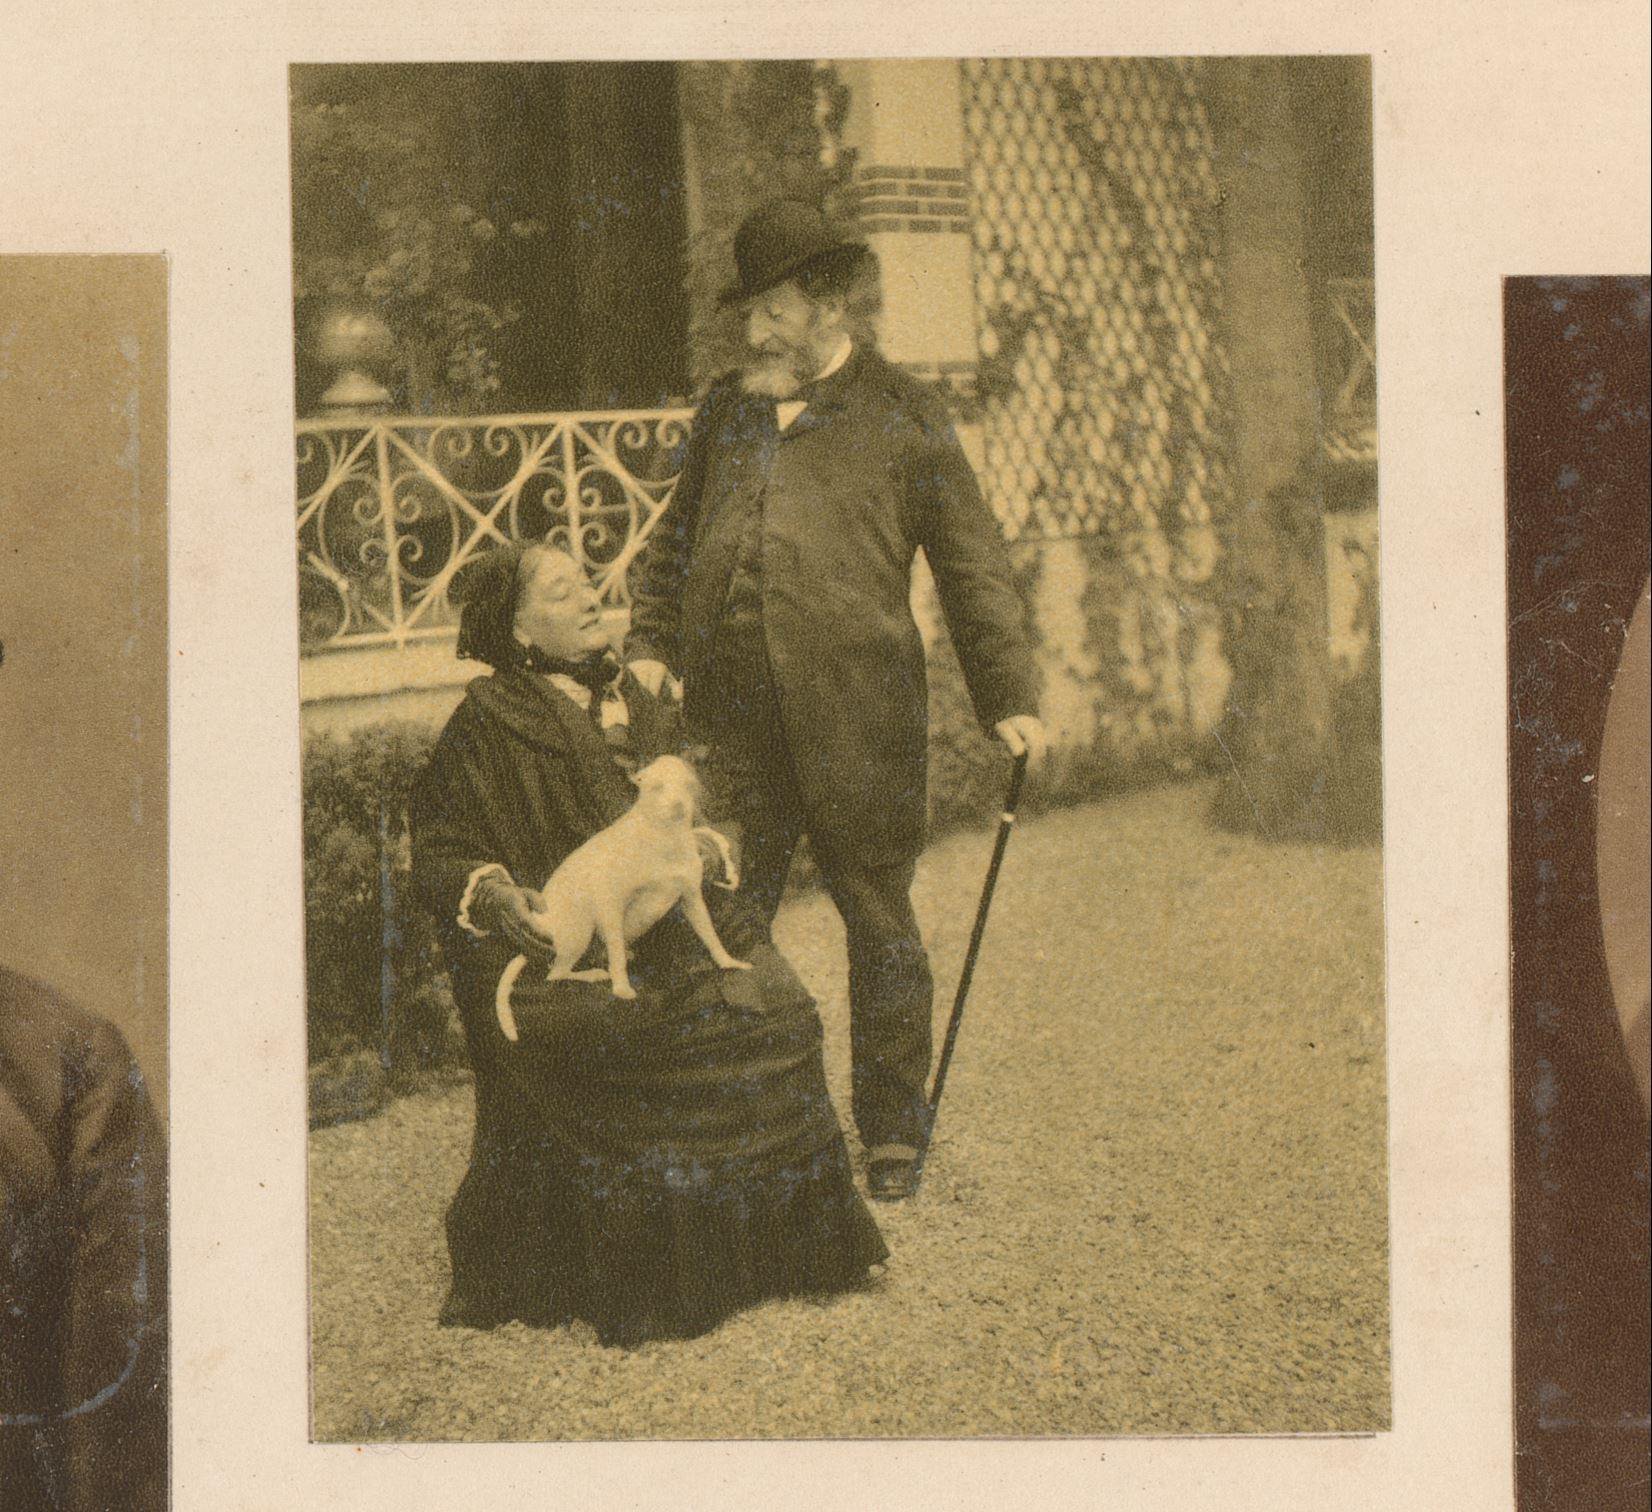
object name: album leaf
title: Émile Augier naast een vrouw met hond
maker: Anonymous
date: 1885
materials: paper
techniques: rotogravure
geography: france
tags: writer, poet, author, france